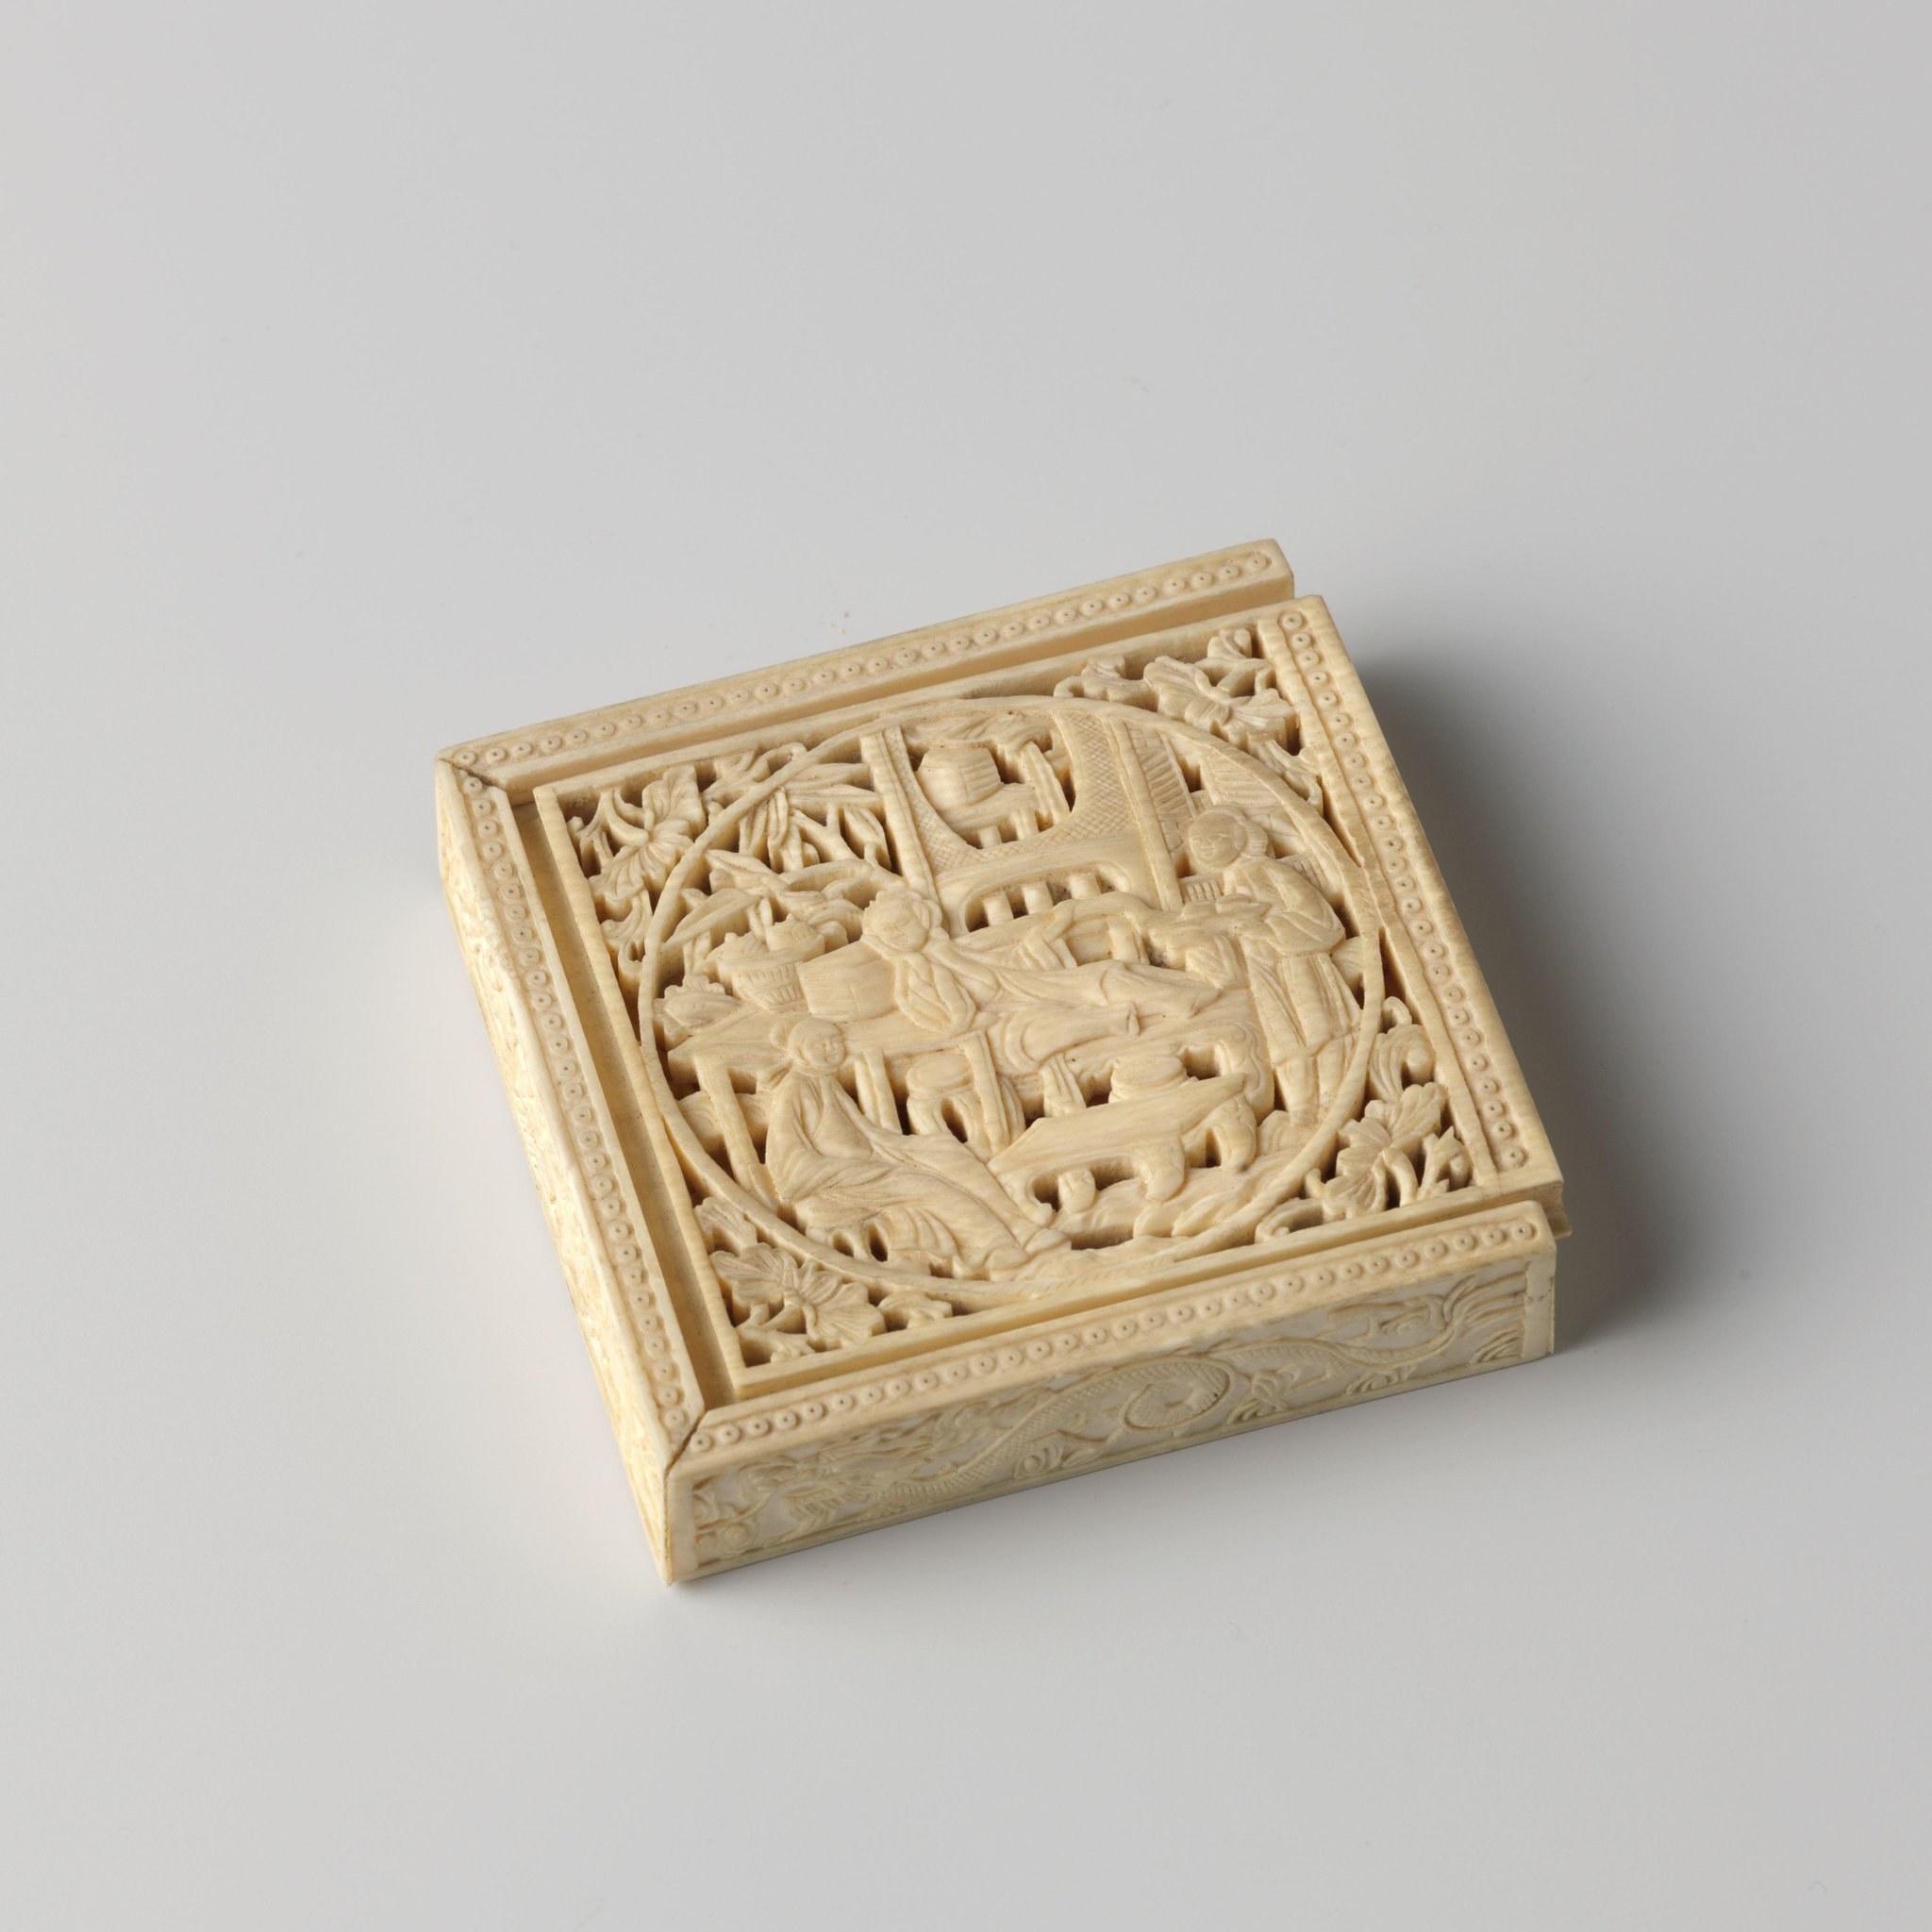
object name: puzzel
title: Puzzel in een ivoren, opengewerkte doos met schuifdeksel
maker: Anonymous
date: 1800-1850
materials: ivory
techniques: cutting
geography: china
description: Vierkante doos met een schuifdeksel, De deksel is opengewerke en bevat een groot medaillon met daarin een op een bank liggende dame die met haar bovenlichaam tegen een stapel boeken aan steunt; daarnaast twee bedienden. In en buiten het medaillon verder bloemranken. De zijkanten zijn tweemaal met een draak en tweemaal met een bloeiende of vruchtdragende boom versierd, in vrij ondiep reliëf. De onderkant met een gezelschap in een landschap in ondiep reliëf. In het doosje zeven ajour gewerkte puzzelstukjes.